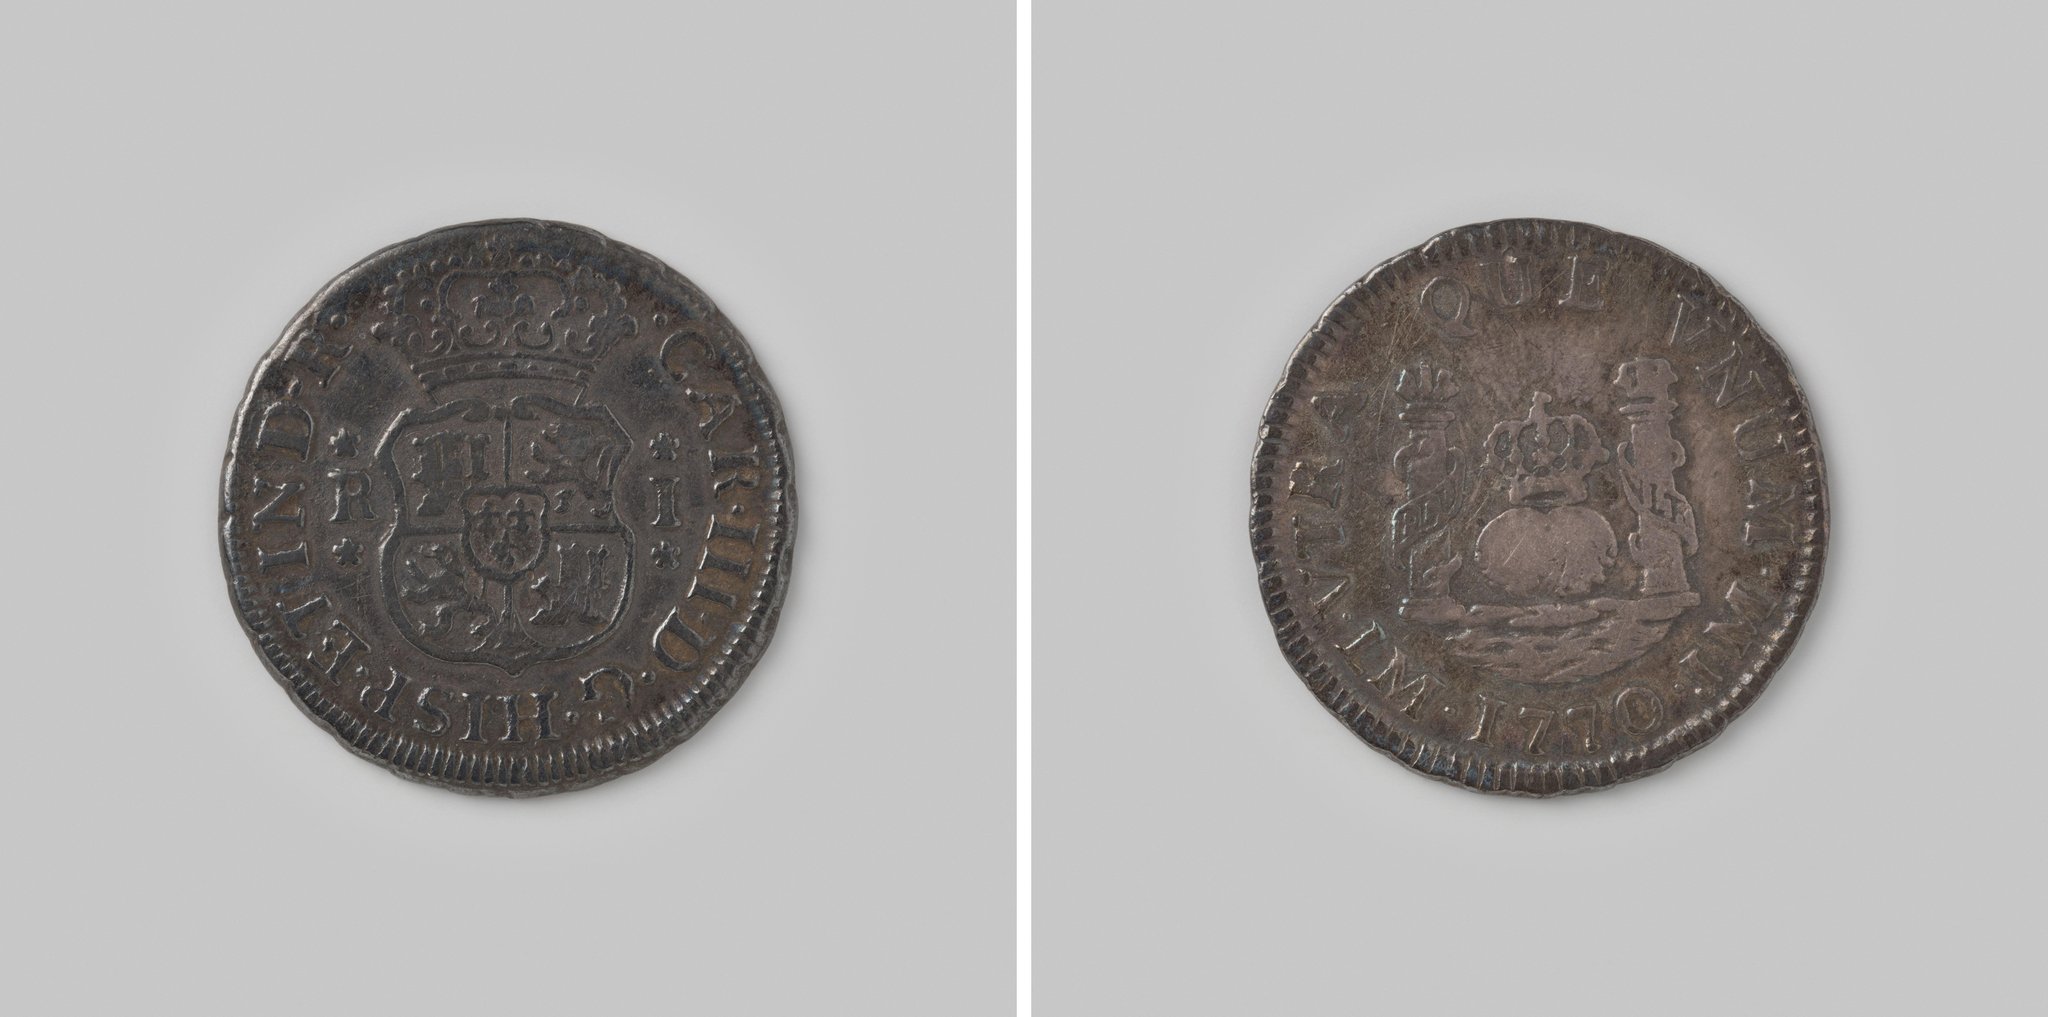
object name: real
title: Reaal uit Peru van Karel III,1770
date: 1770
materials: silver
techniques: striking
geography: lima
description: Zilveren munt. Voorzijde: tussen waarde-aanduiding R I gekroond Spaans wapenschild. Keerzijde: tussen twee uit zee oprijzende gekroonde zuilen, twee wereldbollen, waarop kroon. Jaartal onderaan. Links daarvan muntplaats-aanduiding: LM [=Lima]. Bloemrand.